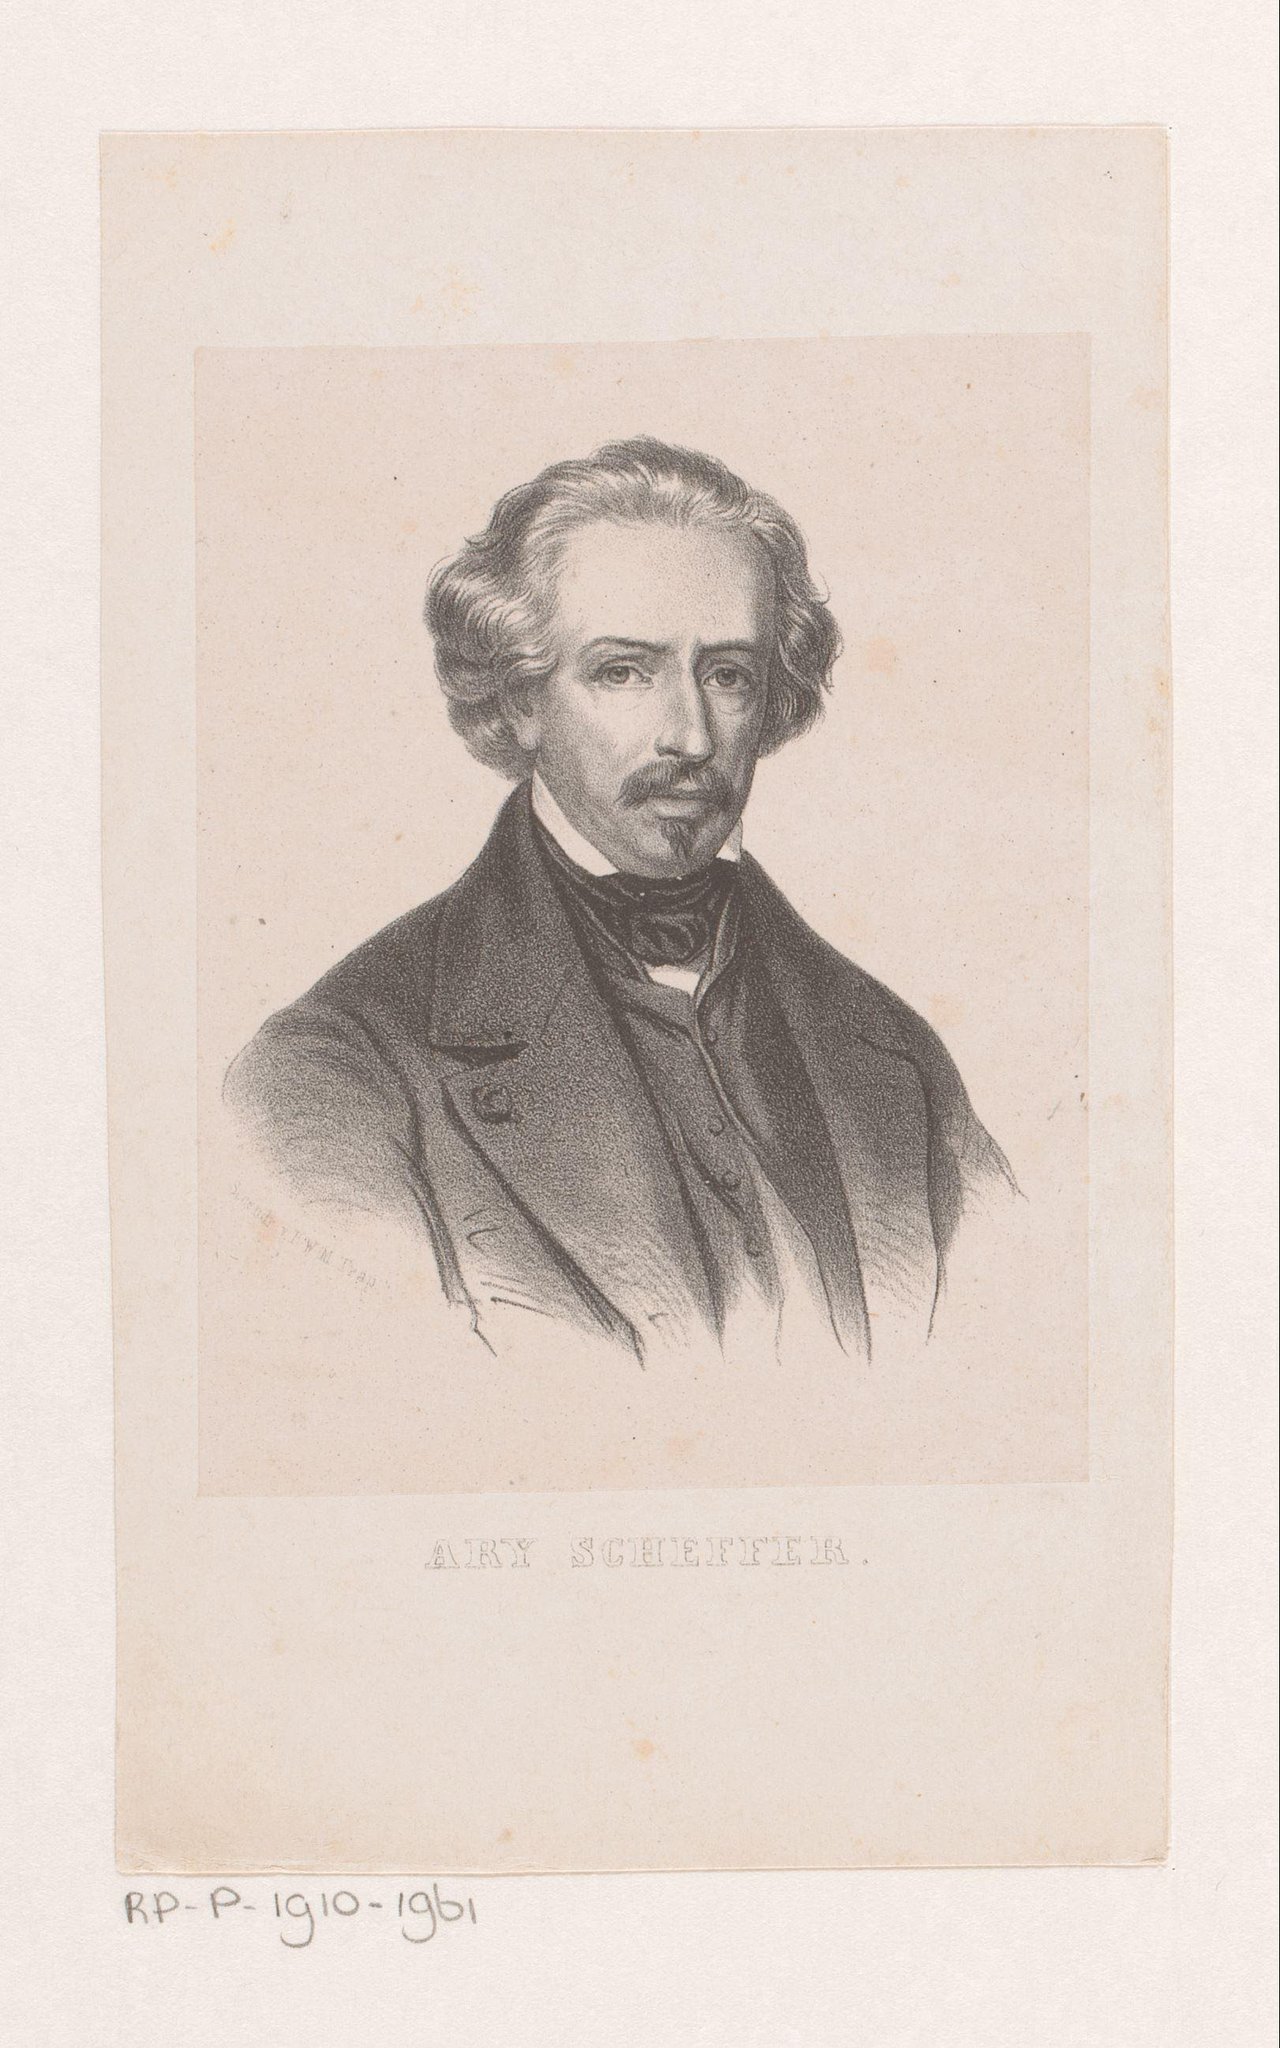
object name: print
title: Ary Scheffer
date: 1858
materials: paper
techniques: lithograph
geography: leiden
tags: dordrecht, painter, draughtsman, sculptor, ary scheffer, historical persons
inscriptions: collector's mark: Lugt 2228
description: Prent uit: Maandelijksche Kronijk. Geschiedenis van den dag, 1858, dl. II.